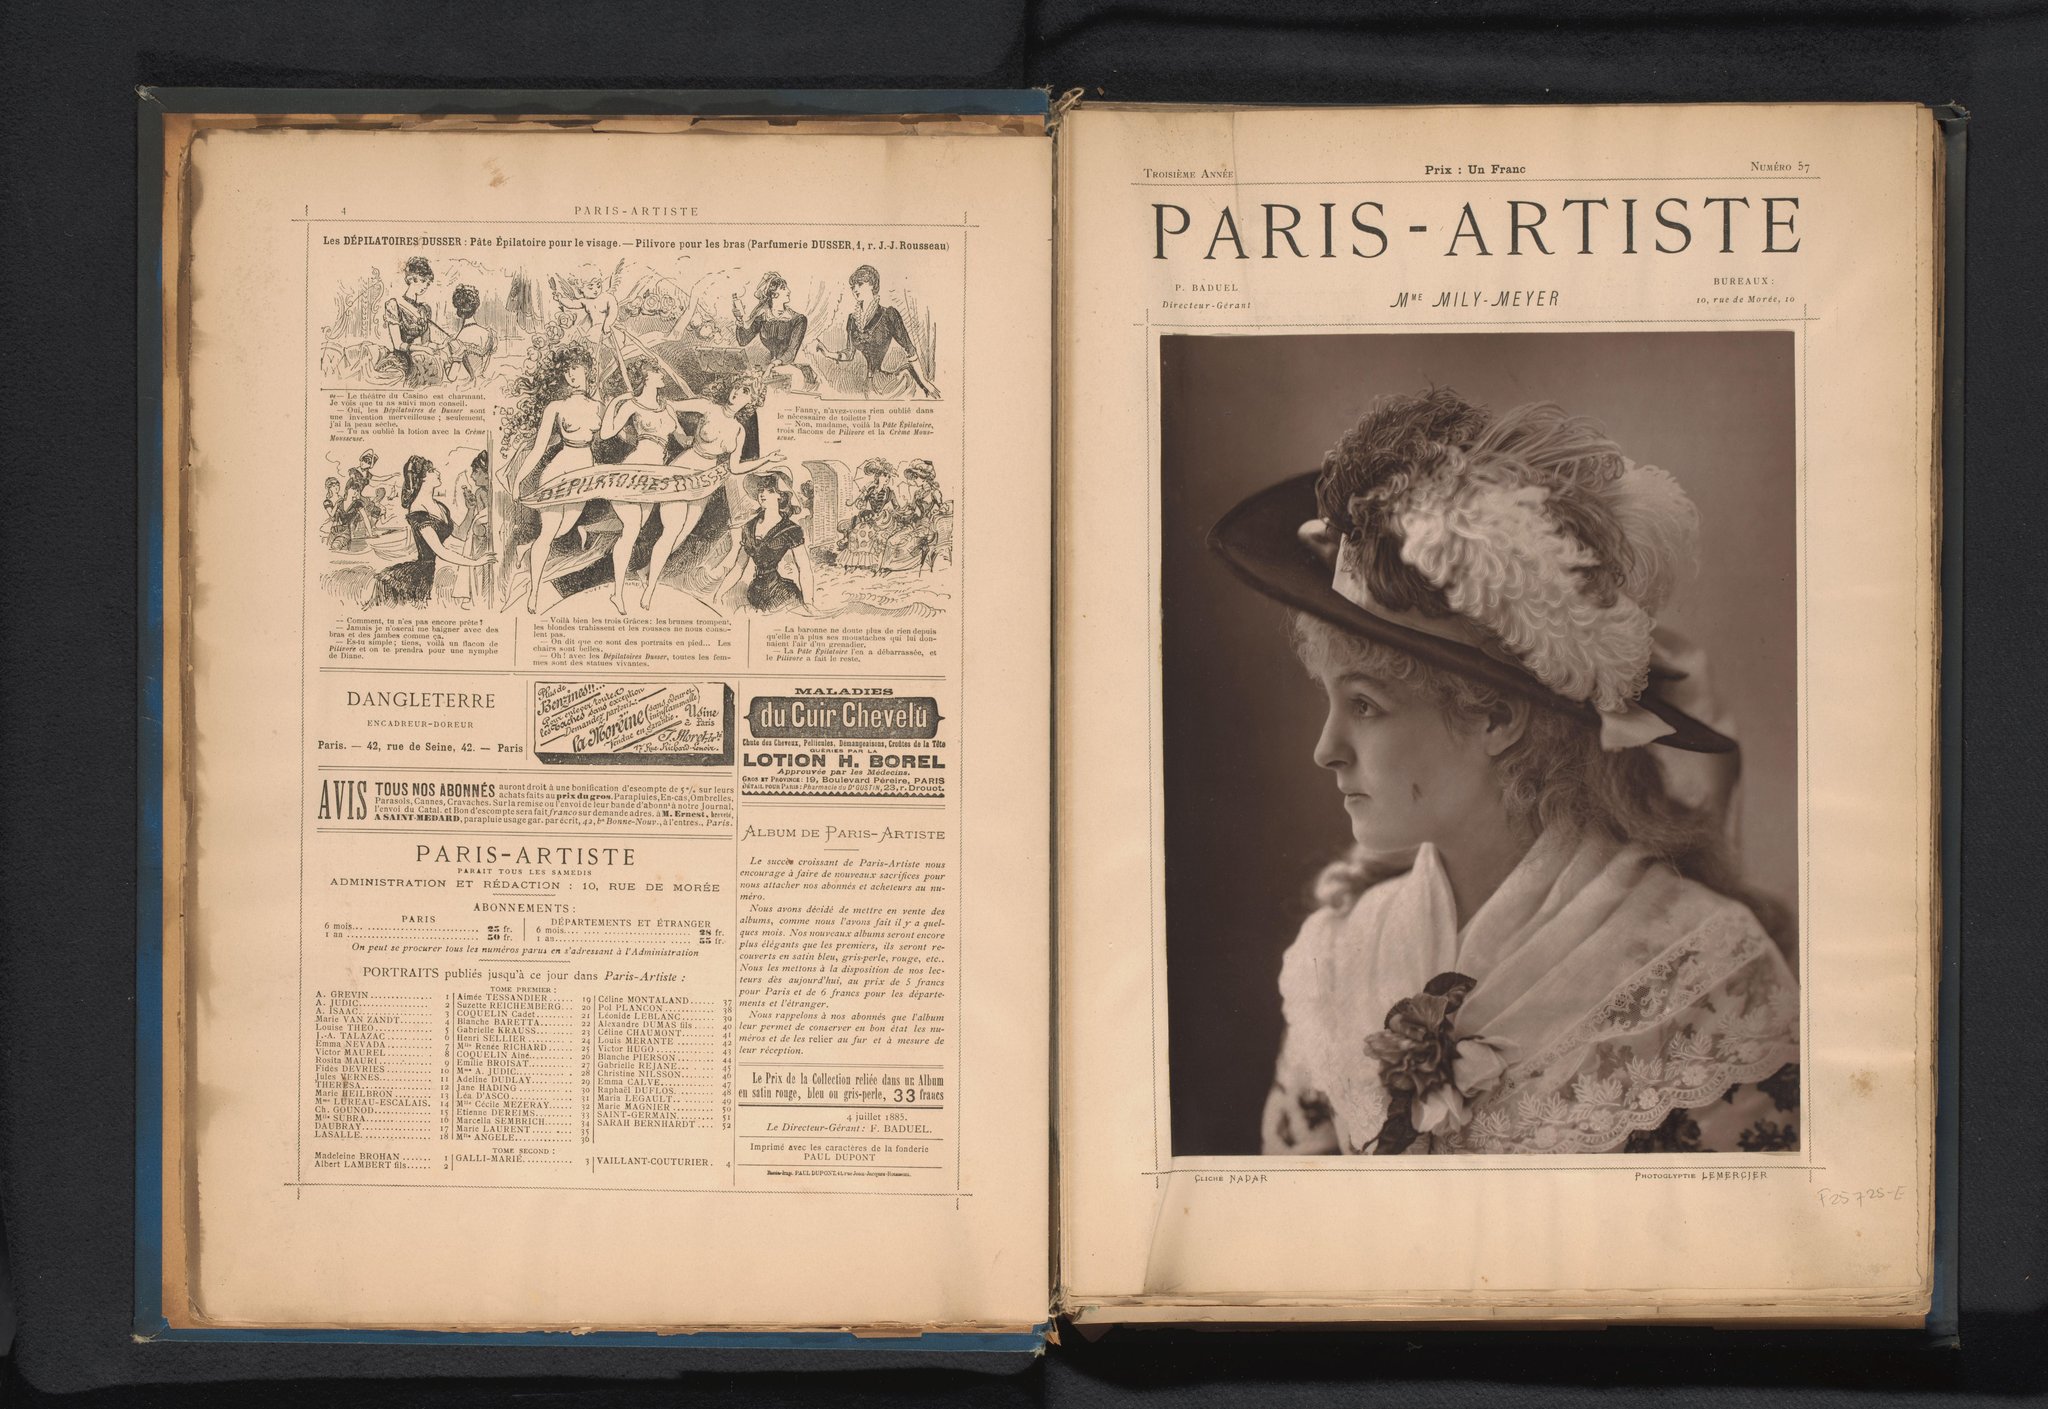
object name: photomechanical print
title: Portret van Émilie Mily Meyer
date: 1880-1885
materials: paper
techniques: woodburytype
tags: historical persons - bb - woman, opera-singer (female)